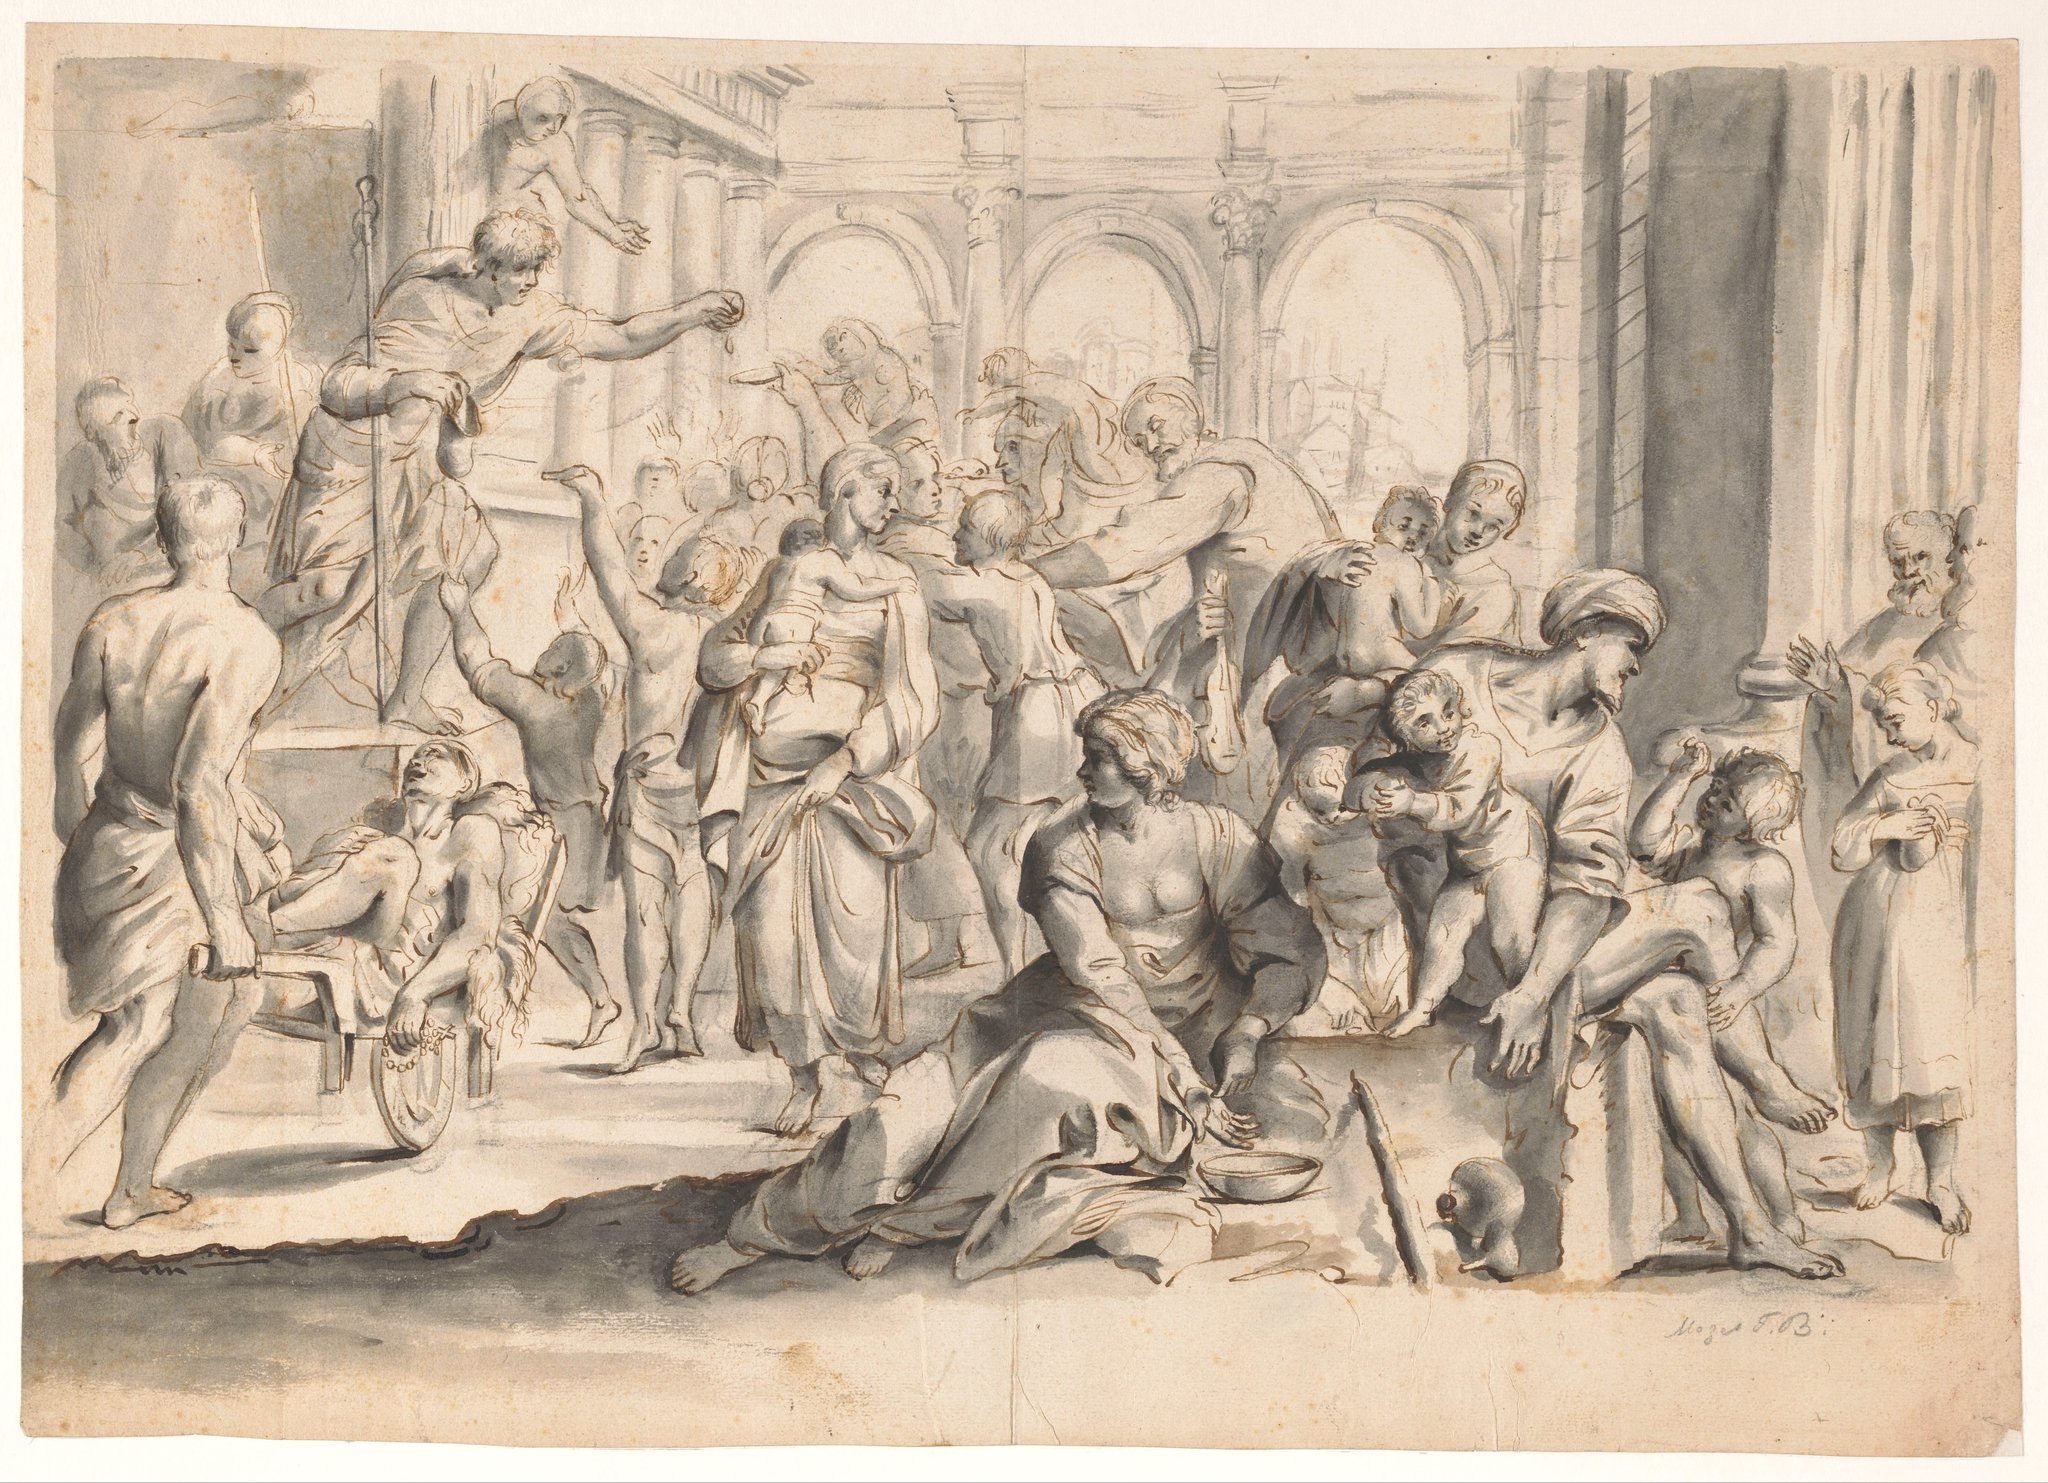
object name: drawing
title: Heilige Rochus die aalmoezen uitdeelt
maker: moses ter borch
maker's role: draughtsman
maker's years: 1645-1667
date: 1659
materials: chalk, ink, paper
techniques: brush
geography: zwolle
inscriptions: annotation: ‘gett hirein sin 18 / 50’, annotation: ‘Moses TB’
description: Heilige Rochus die aalmoezen uitdeelt; op verso een schets voor de tekening op recto.